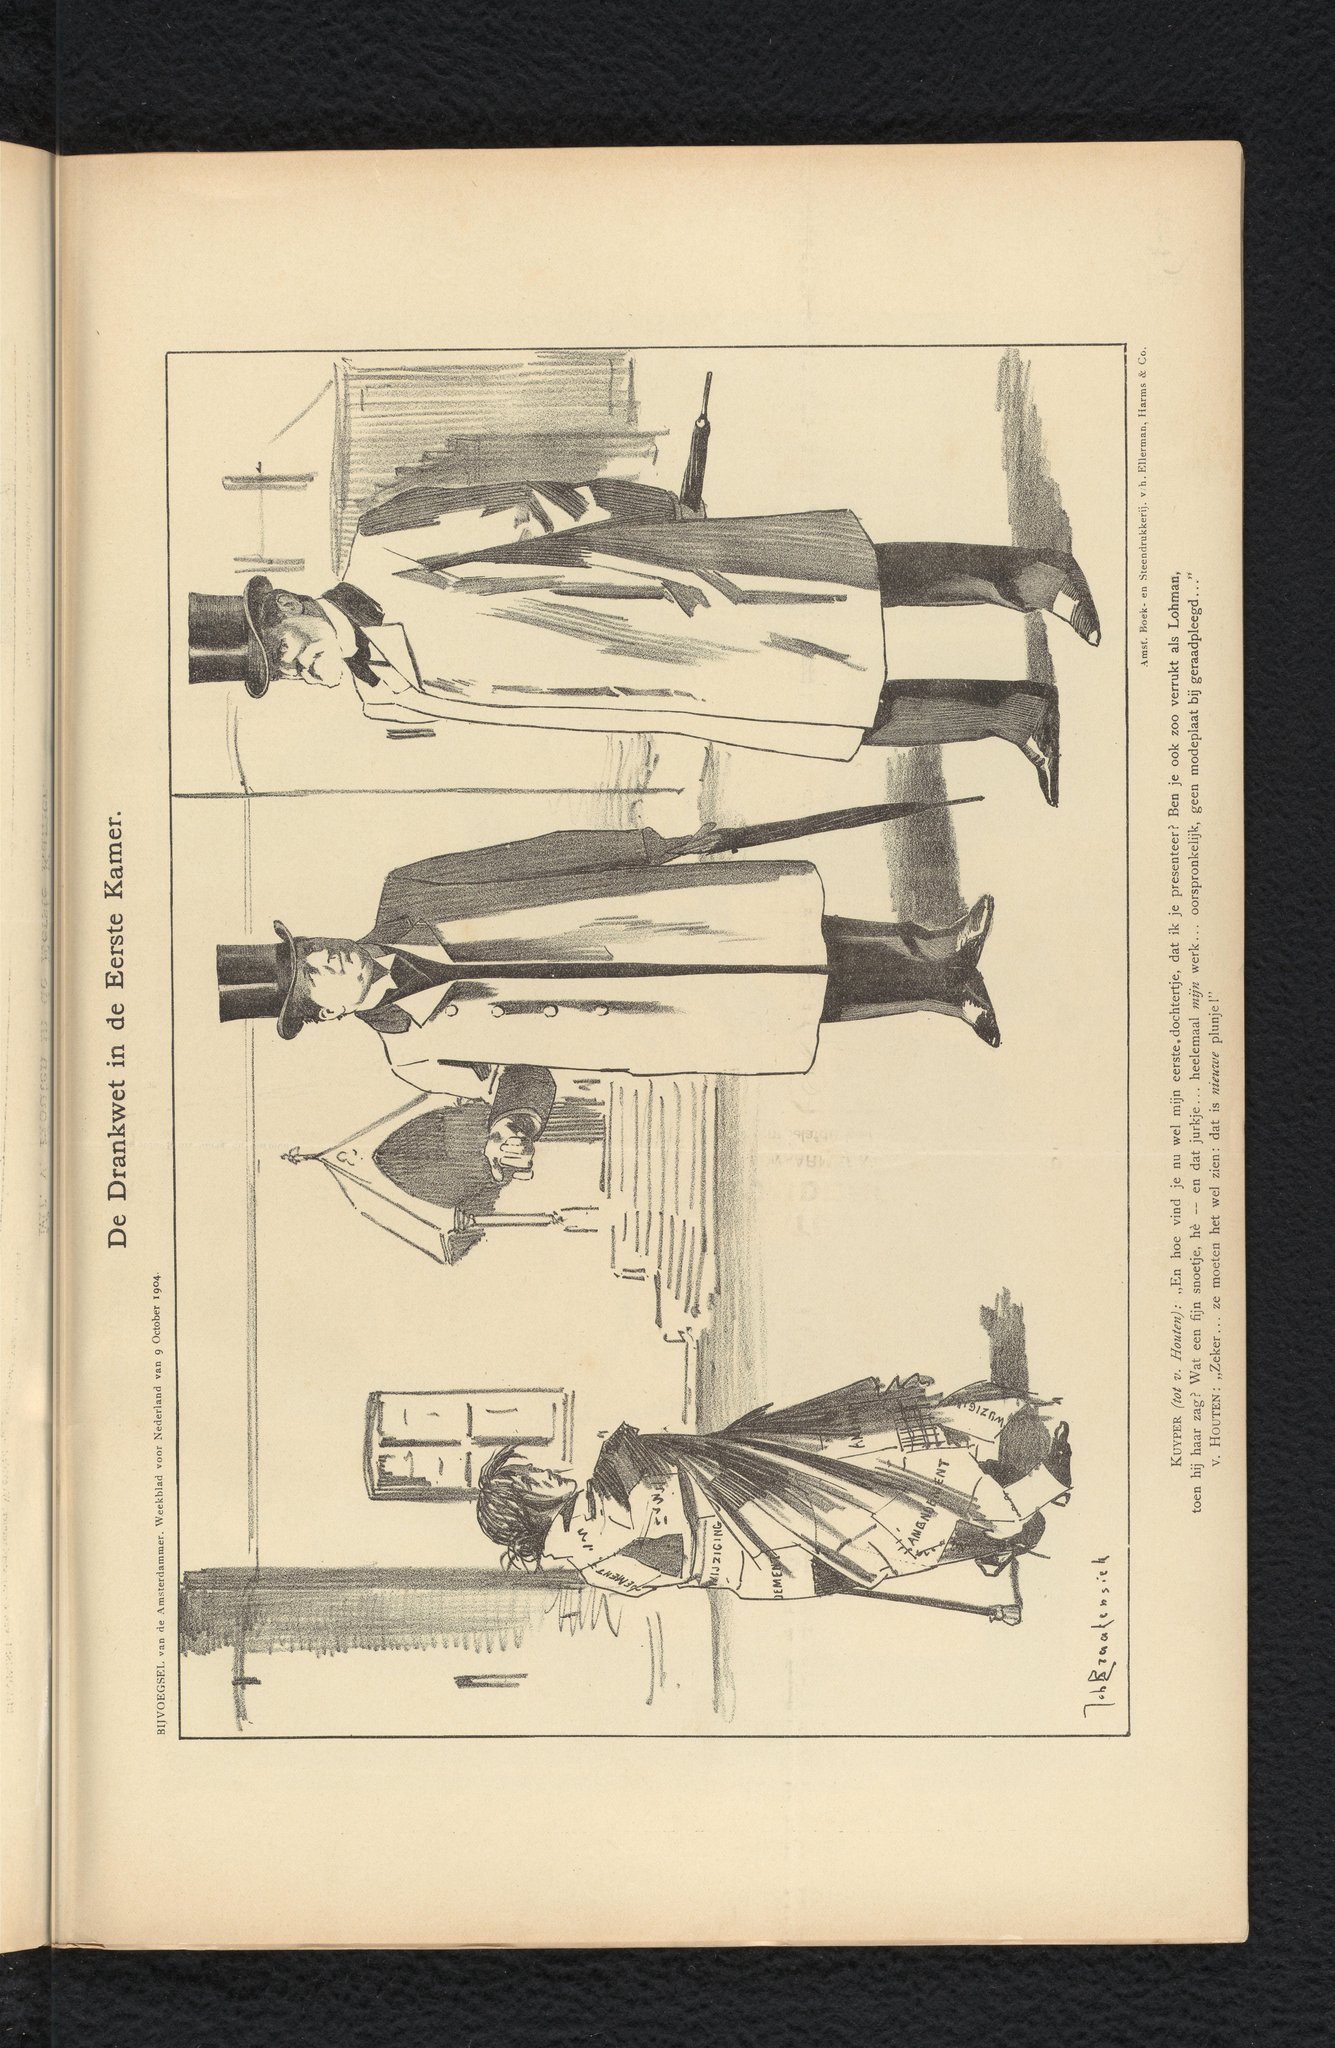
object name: cartoon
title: De Drankwet in de Eerste Kamer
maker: johan braakensiek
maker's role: draughtsman, print maker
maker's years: 1858-1940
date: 1904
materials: paper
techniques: lithograph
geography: netherlands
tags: the hague, abraham kuyper, samuel van houten, clothed in rags, political caricatures and satires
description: Premier Kuyper en Samuel van Houten als kamerlid van de Eerste Kamer bij het arme in lompen gehulde kind, de Drankwet voorstellende.